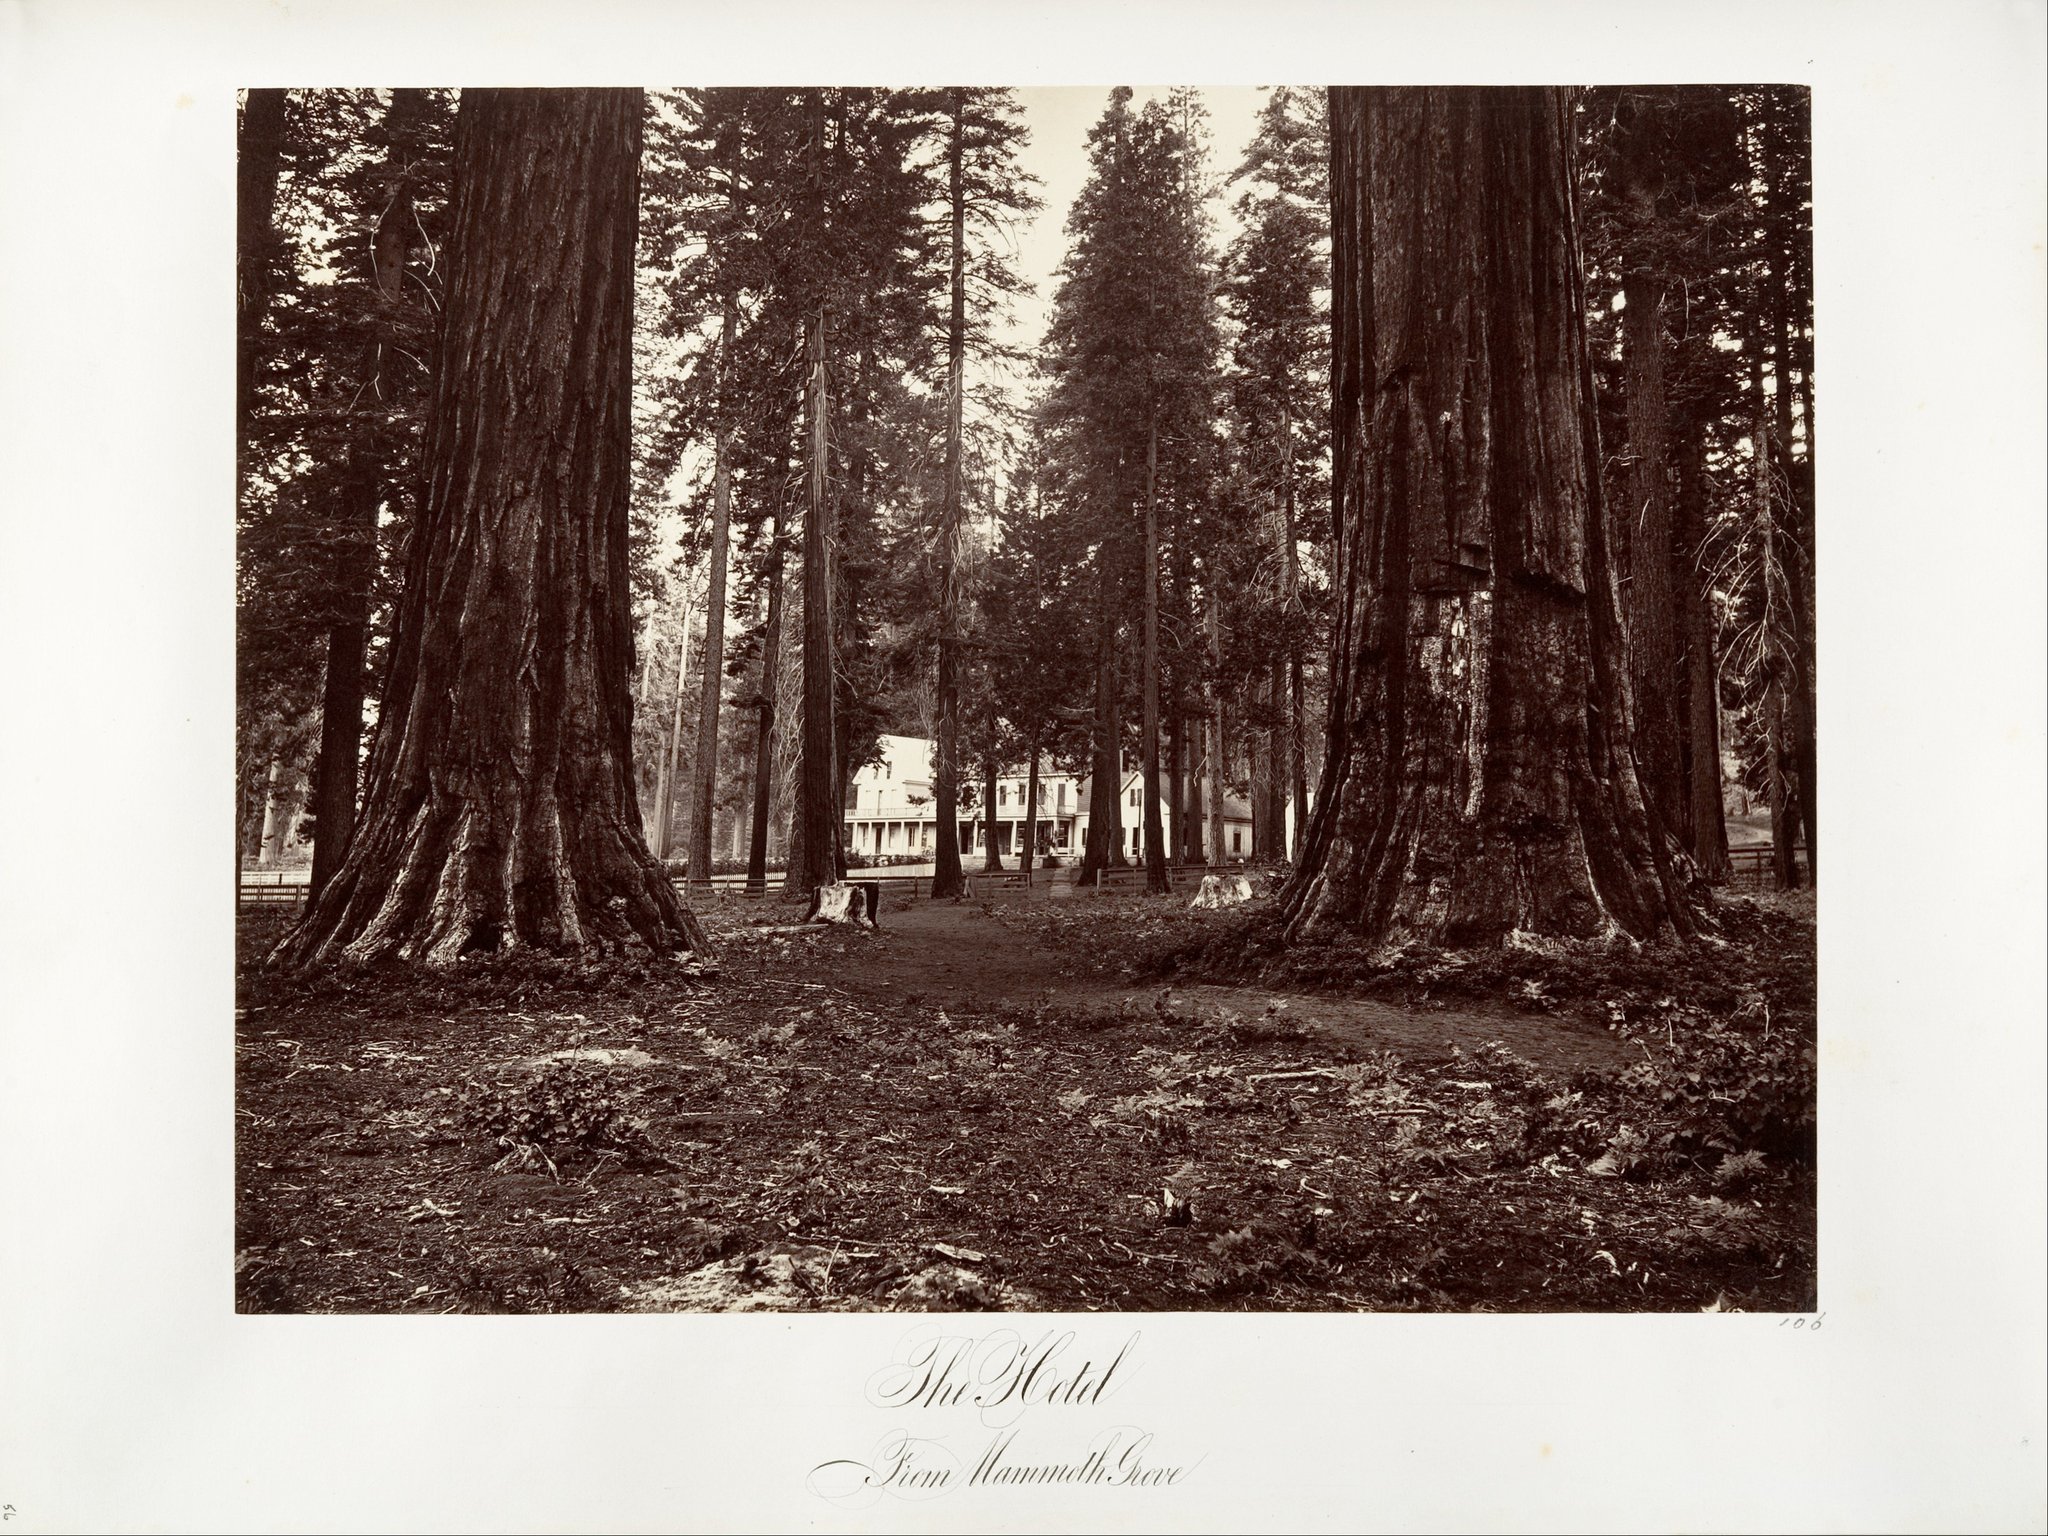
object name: photograph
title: The Hotel from Mammoth Grove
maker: carleton e. watkins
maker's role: artist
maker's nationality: american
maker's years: 1829-1916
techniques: albumen silver print, glass negative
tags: buildings,forests